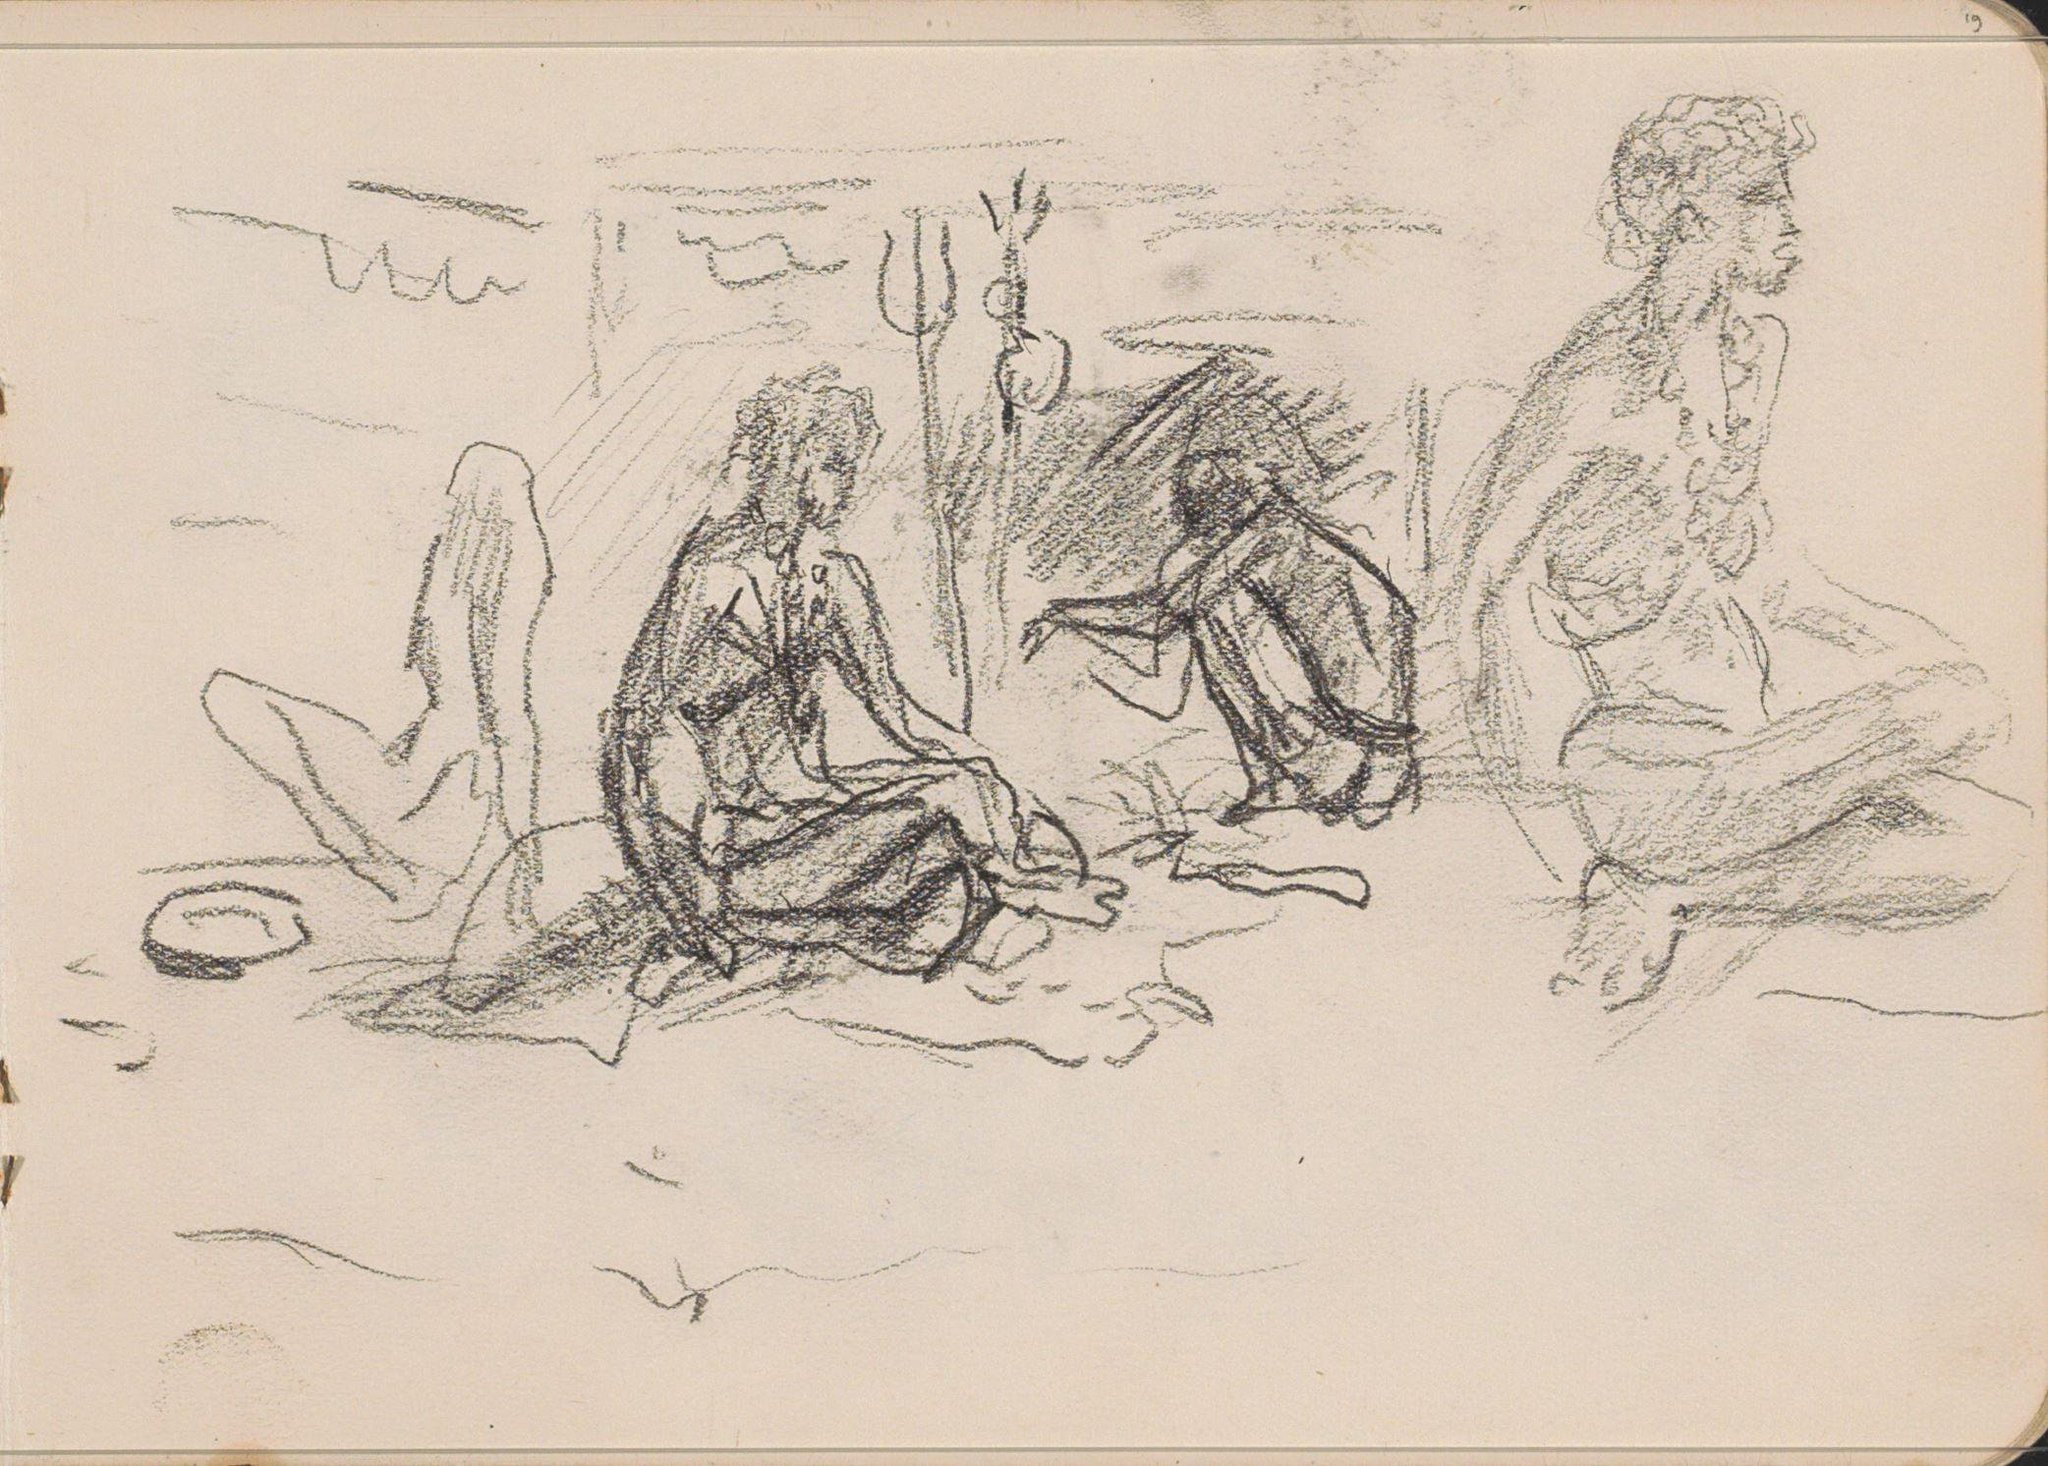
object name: sketchbook leaf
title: Zittende Indiërs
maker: marius bauer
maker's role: draughtsman, print maker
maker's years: 1867-1932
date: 1924-1925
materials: chalk, paper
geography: india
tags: sitting figure, necklace, asiatic races and peoples: indians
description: De figuur op de voorgrond zit op een kleed en draagt een halsketting. Pagina 19 uit een schetsboek met 23 bladen.